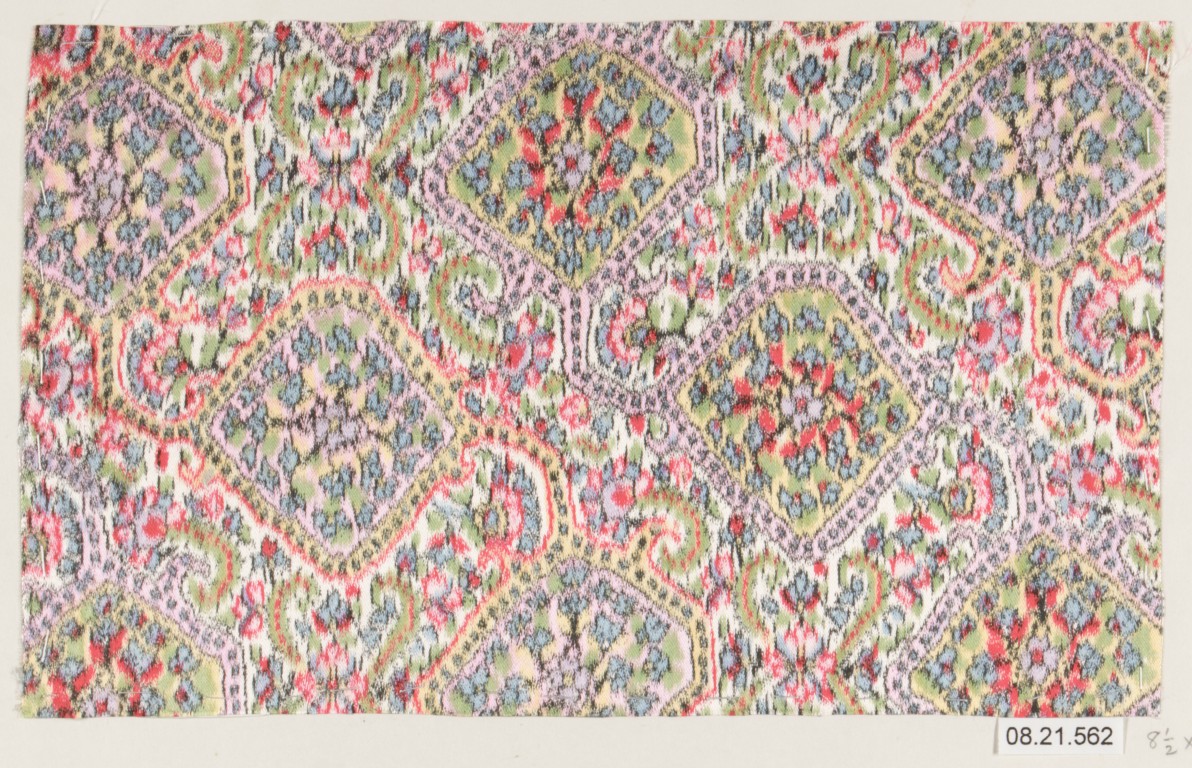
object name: textile sample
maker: Anonymous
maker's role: designer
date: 1900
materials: silk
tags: flowers